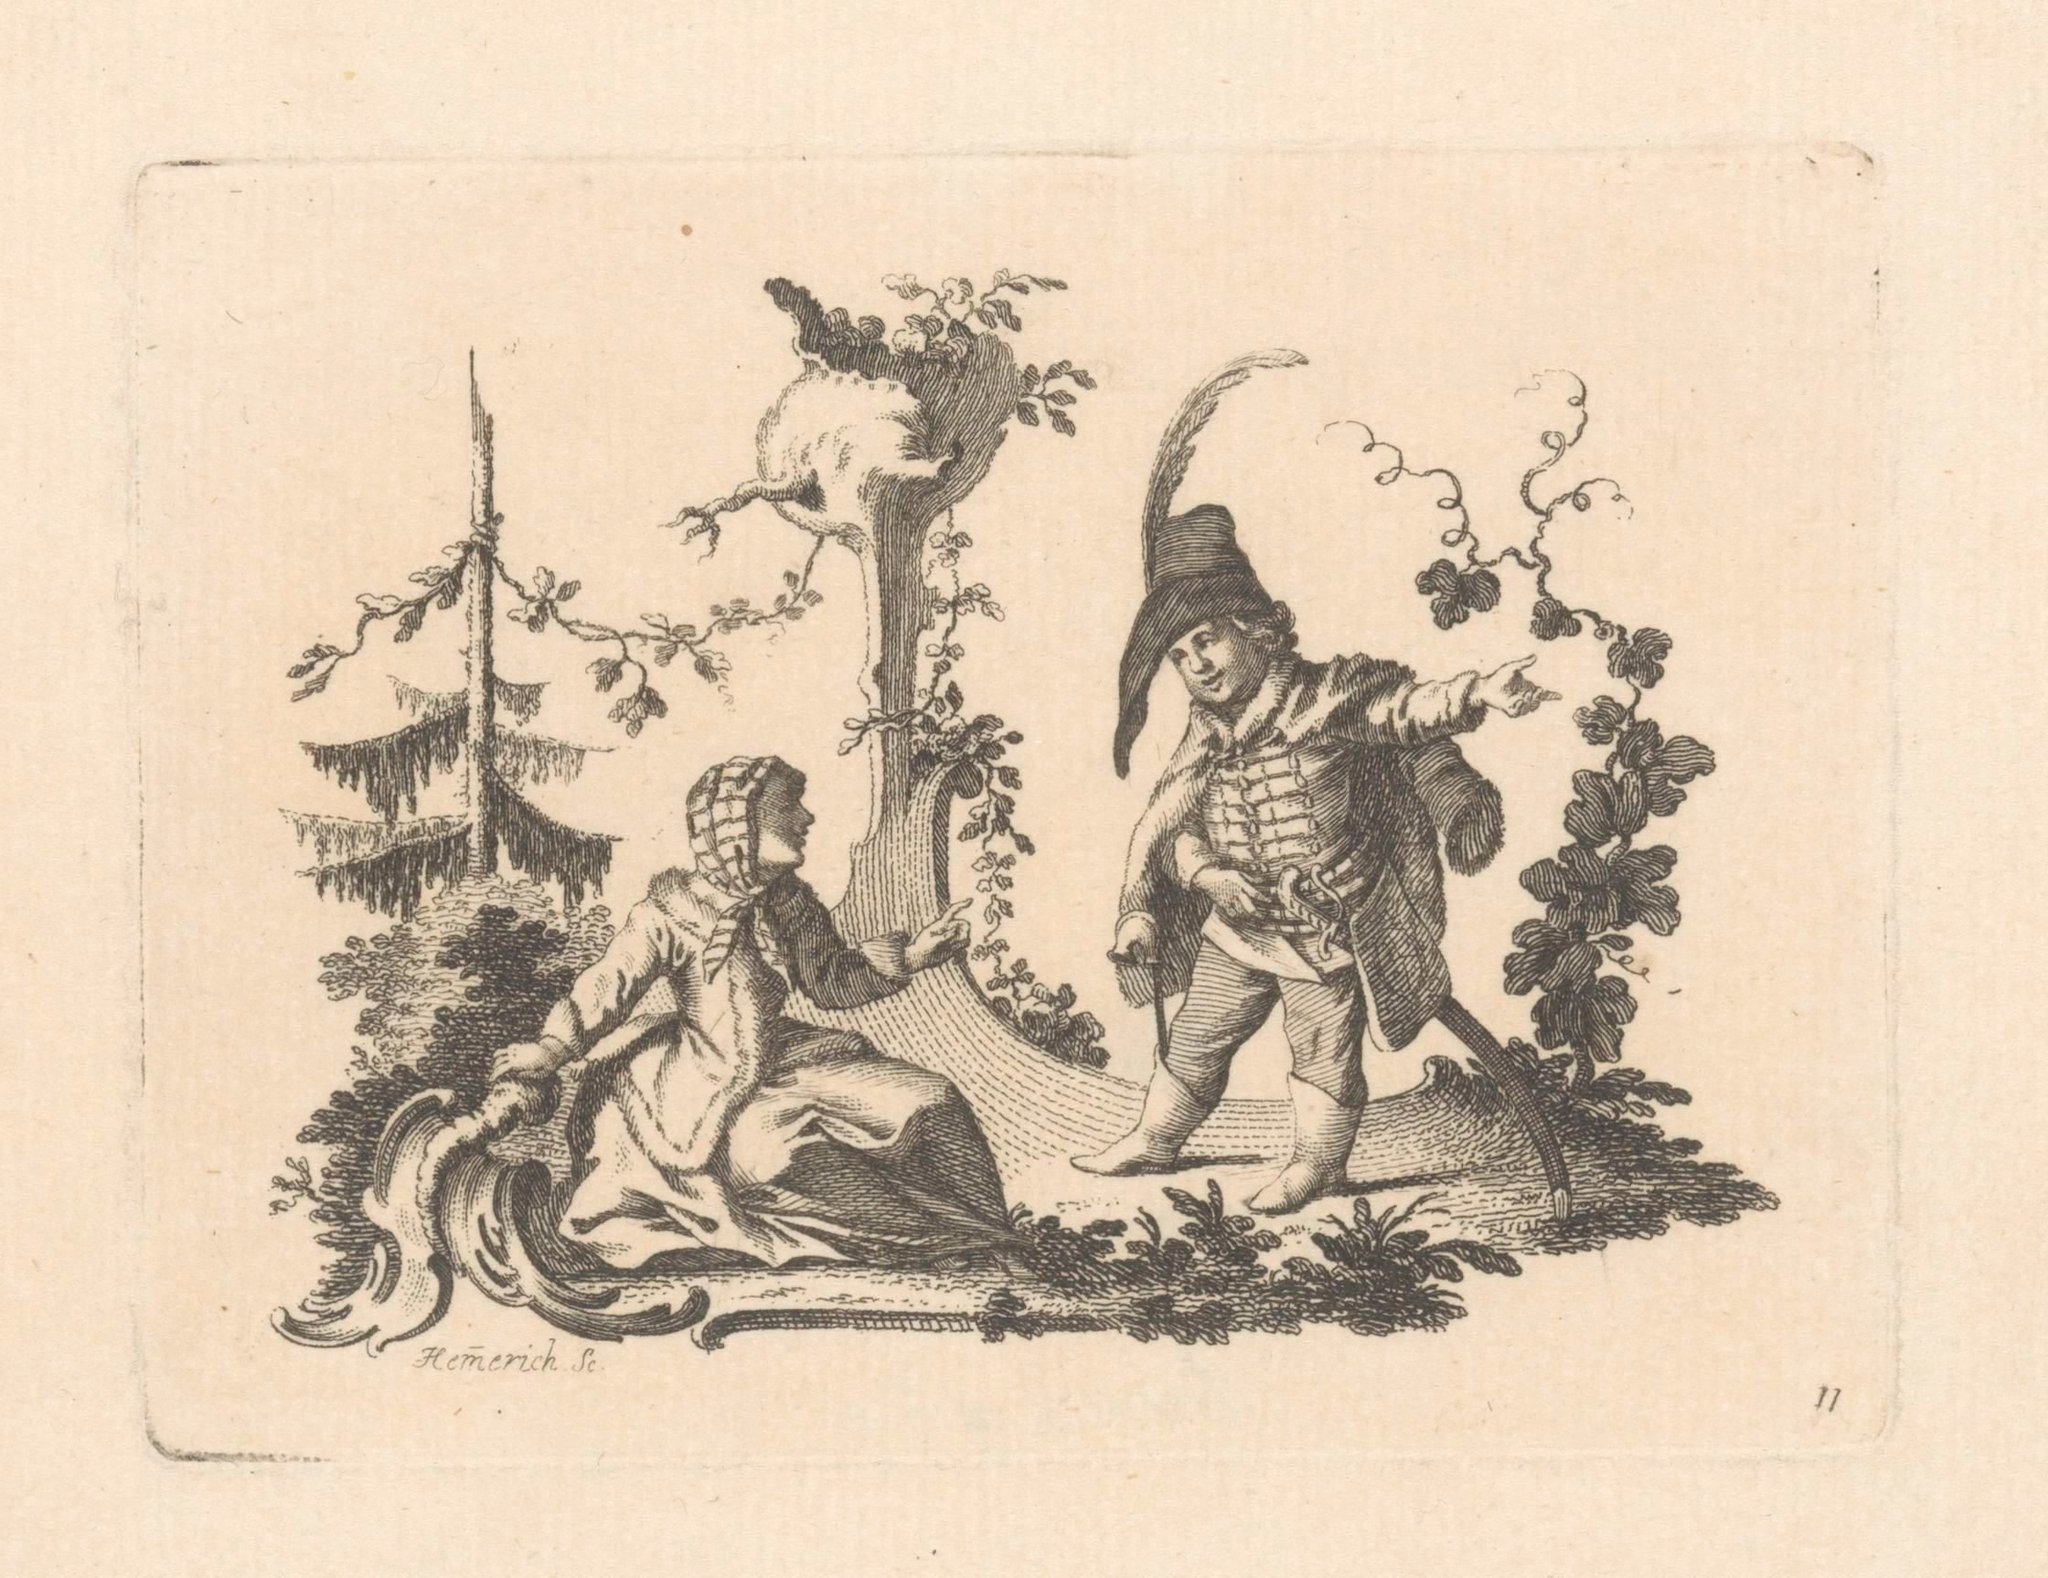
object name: print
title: Caffe The und Tobac Zierathen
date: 1731-1780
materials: paper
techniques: engraving, etching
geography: london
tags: conversation, dialogue; conversation piece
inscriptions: collector's mark: Lugt 2228, collector's mark: Lugt 2760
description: In een landschap met rocaille ornament is een man in gesprek met een zittende vrouw.